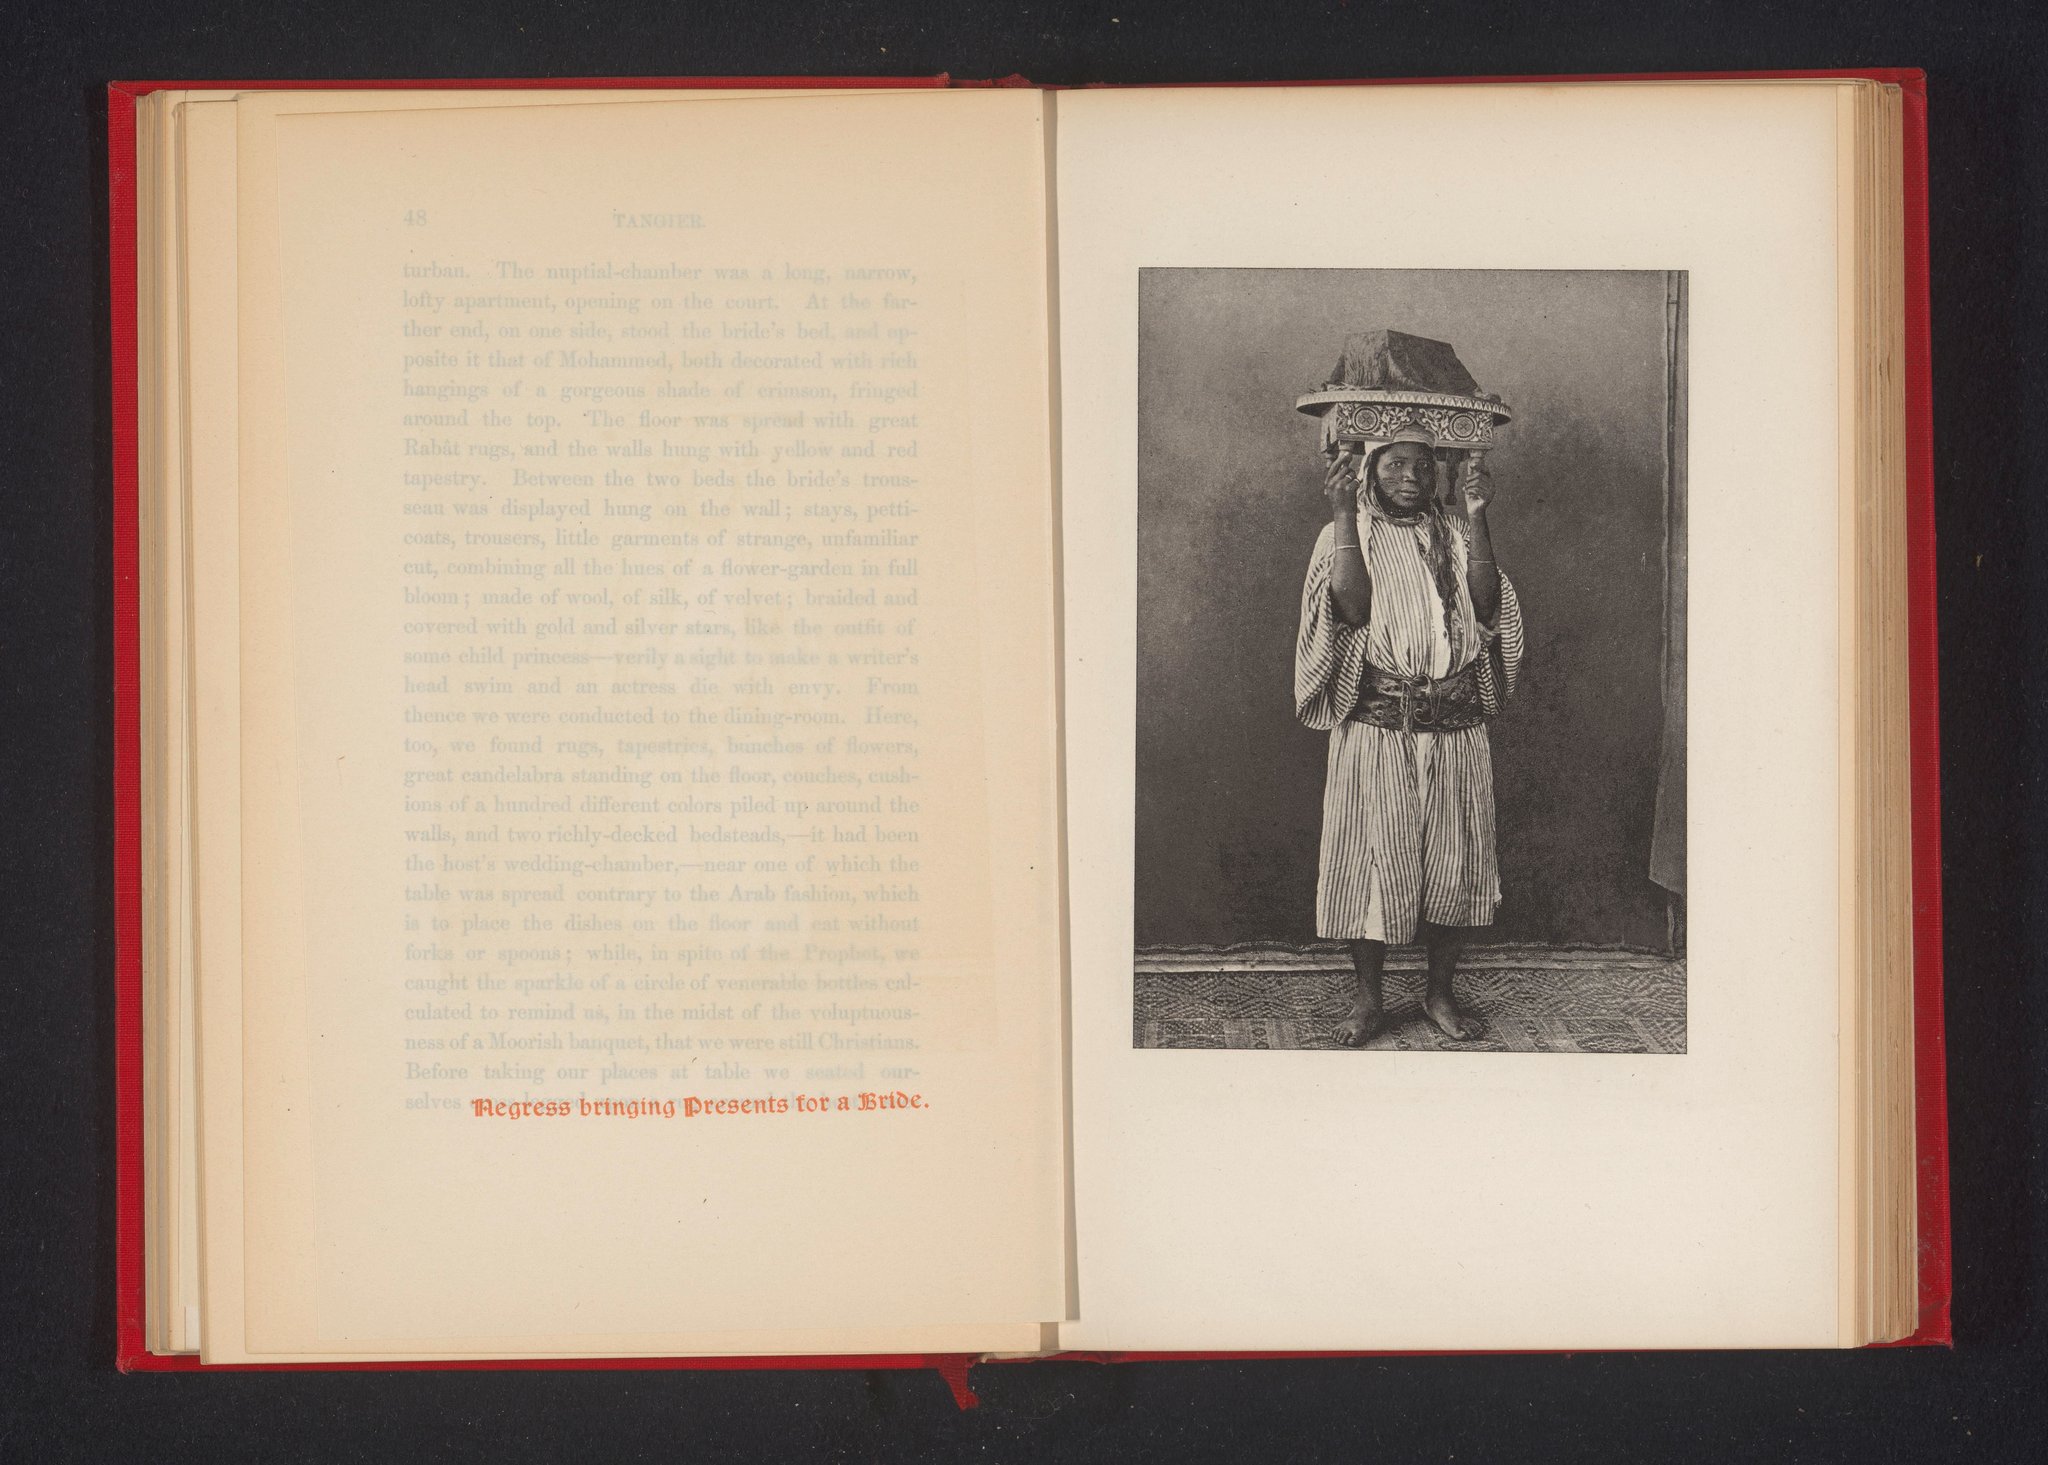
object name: page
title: Portret van een onbekende vrouw met een tafel op het hoofd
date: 1887-1897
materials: paper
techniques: photoaquatint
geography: morocco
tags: adult woman, carrying something on the head or on the shoulders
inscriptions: title: ‘Negress bringing Presents for a Bride.’